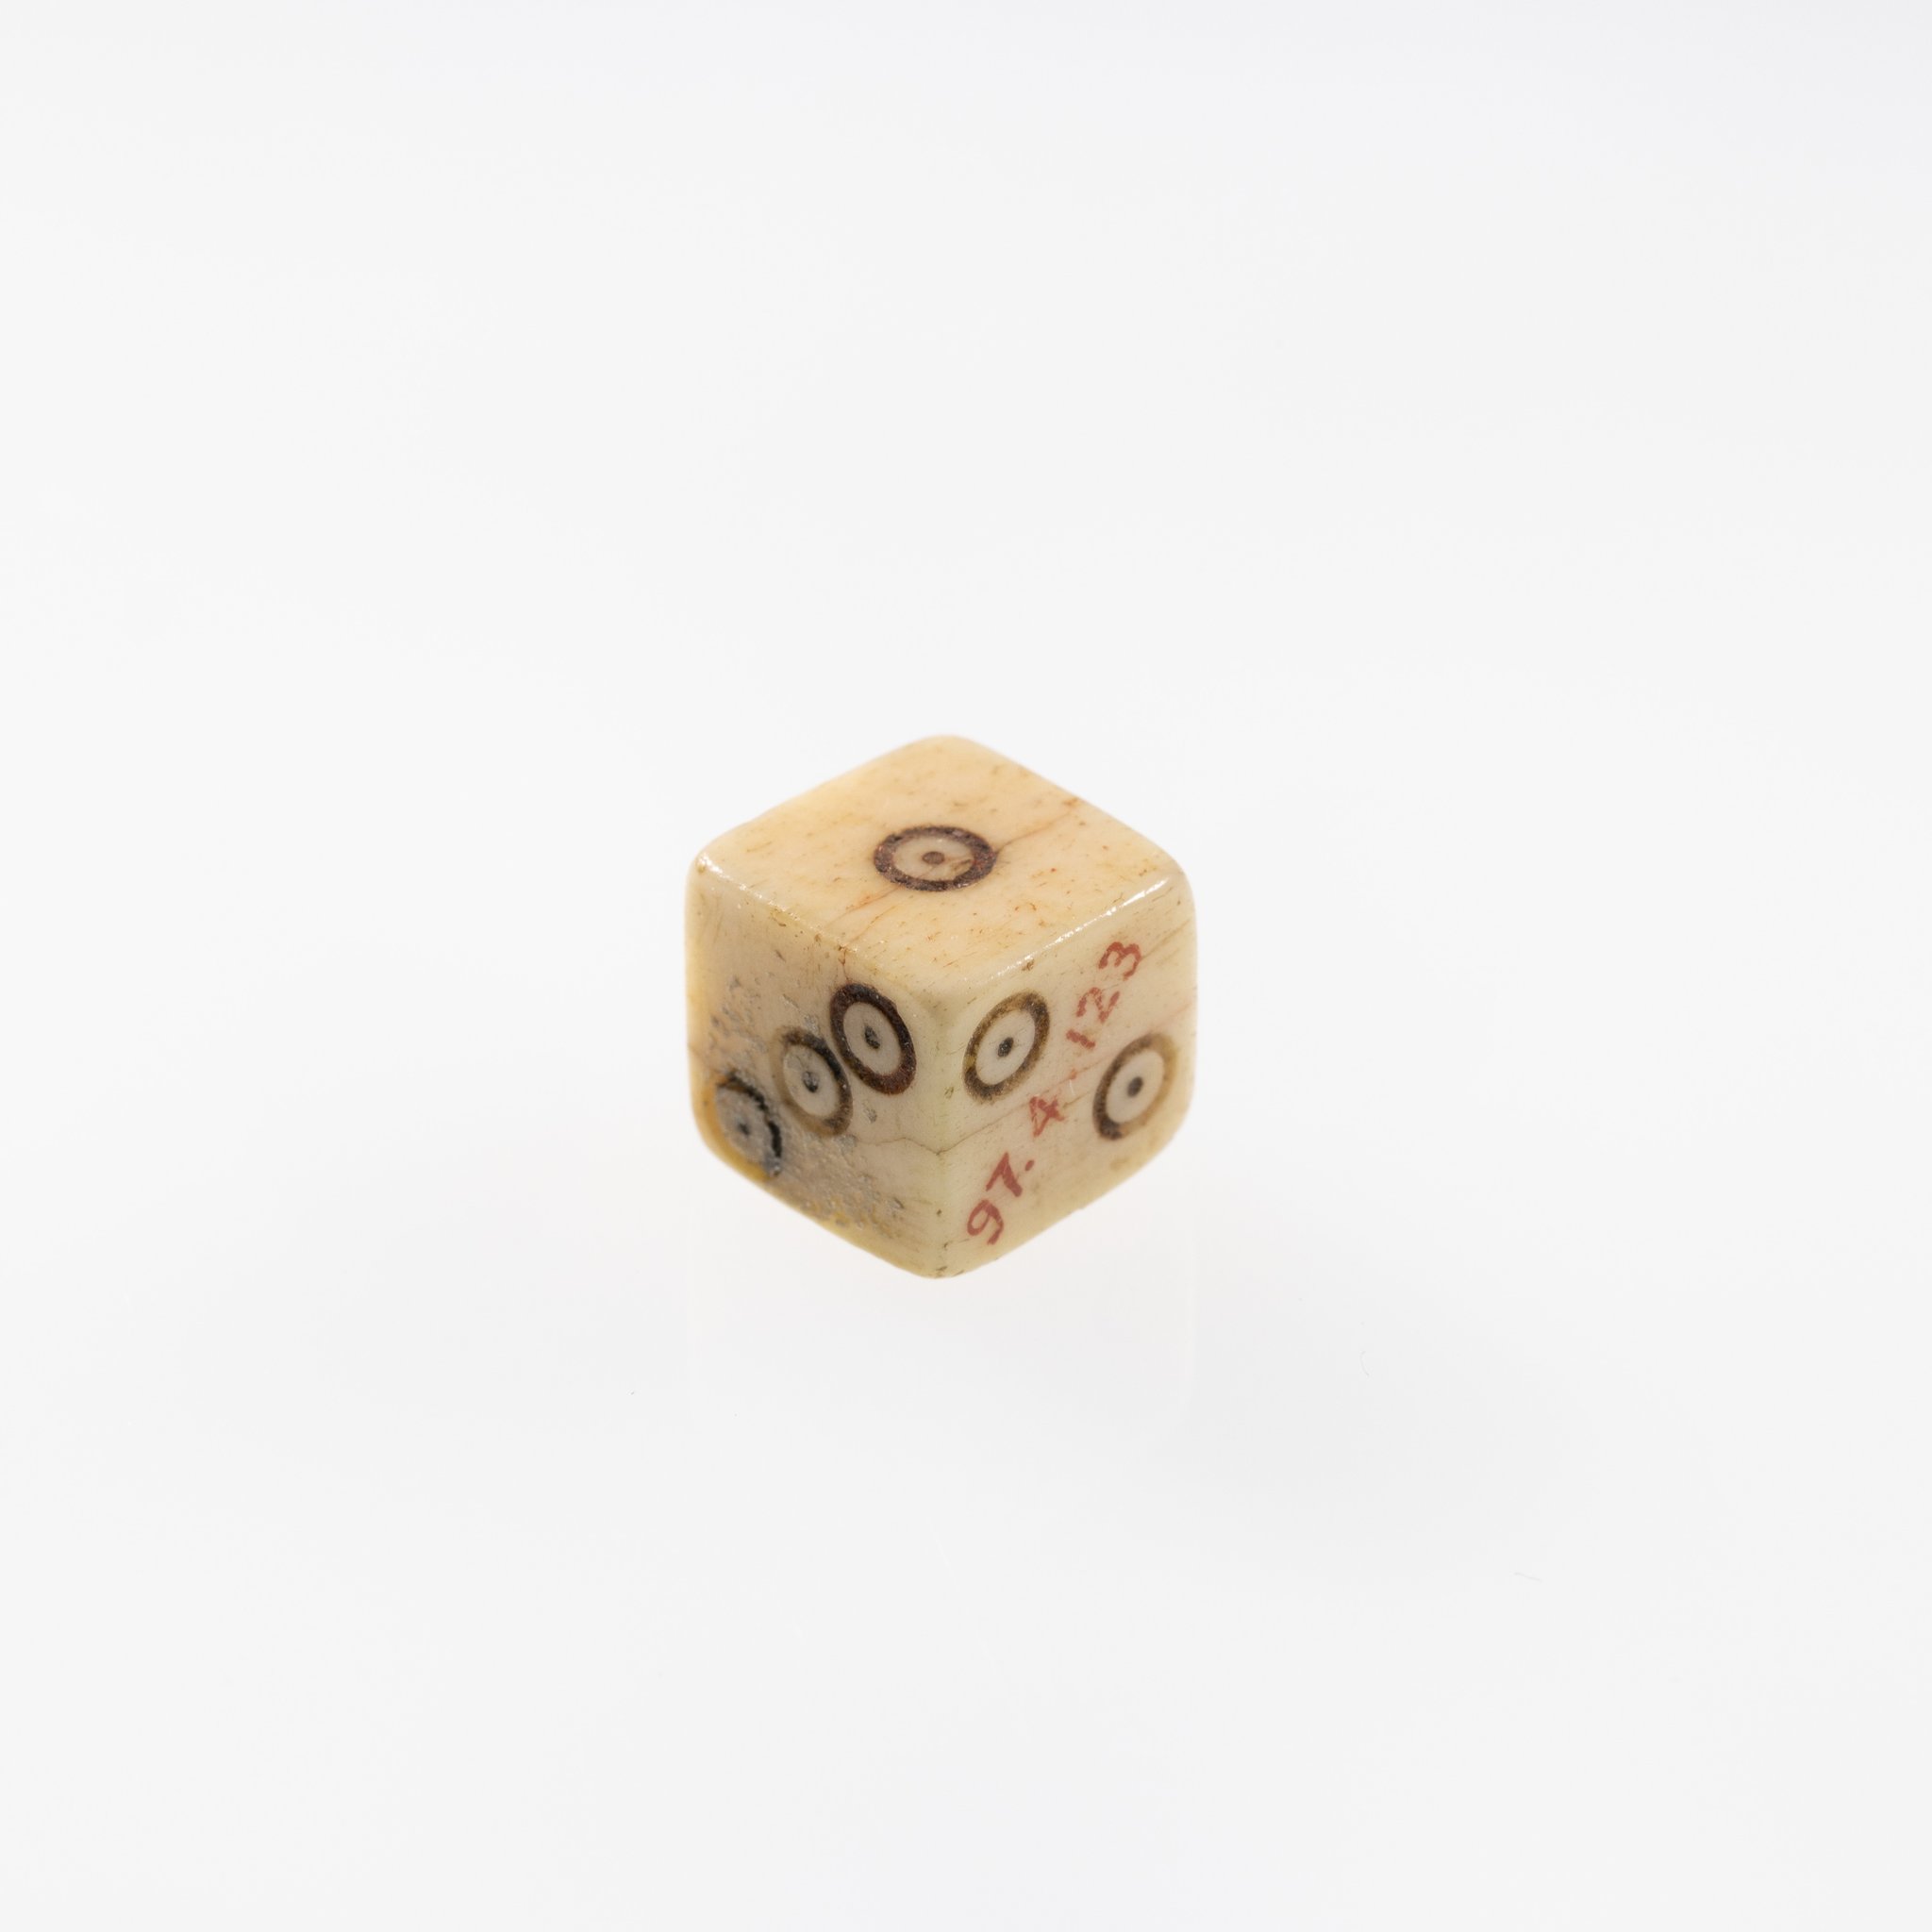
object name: dice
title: Die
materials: ivory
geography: egypt